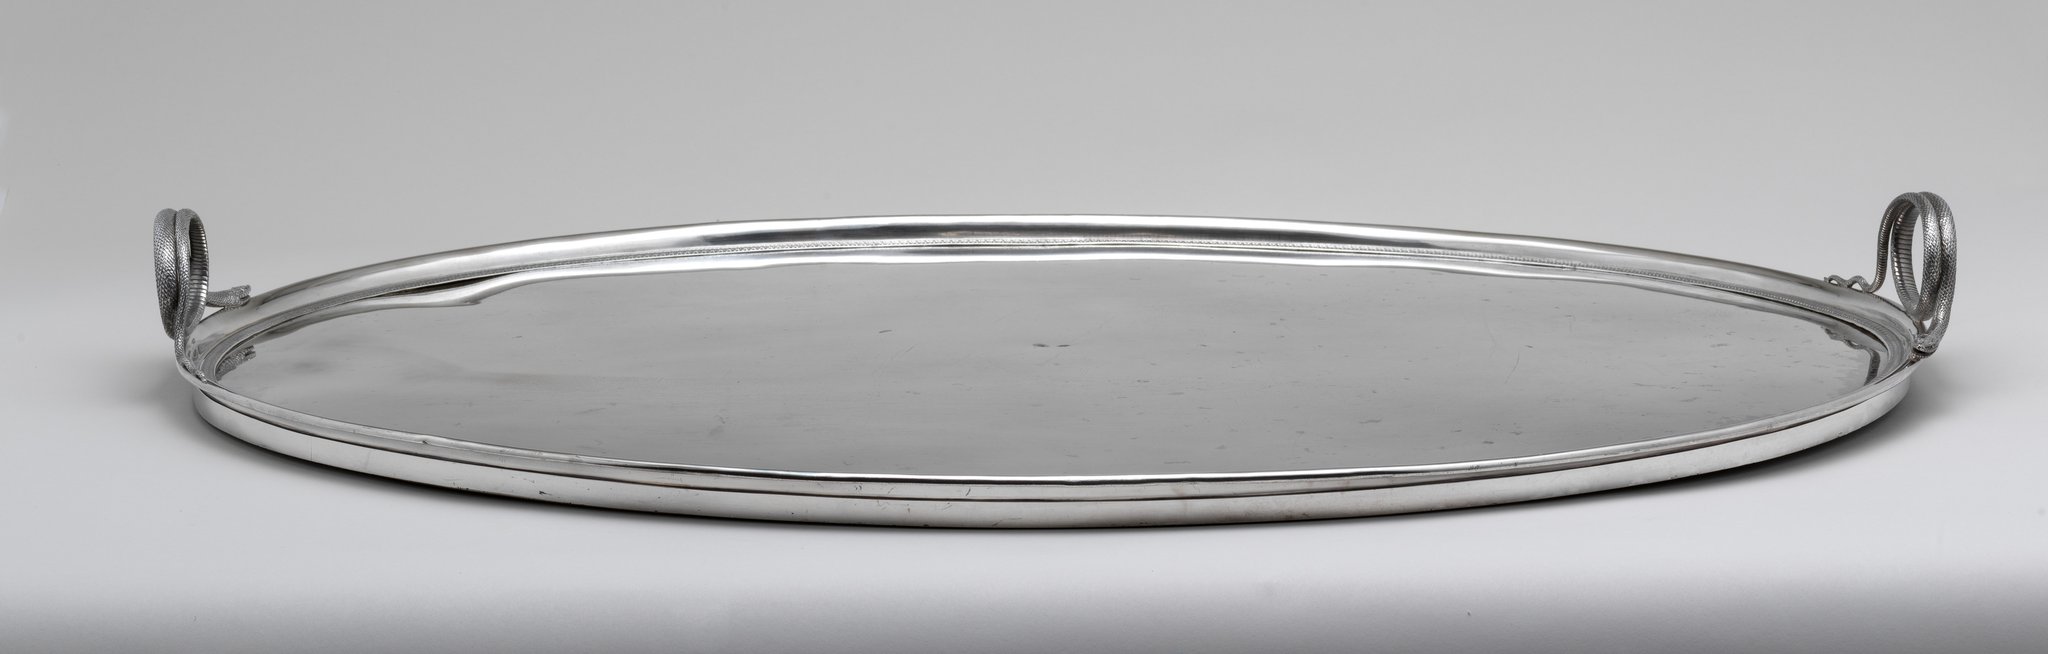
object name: tray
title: Tray (part of a service)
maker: marc jacquart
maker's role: maker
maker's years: 1767-1859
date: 1809-1819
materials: silver